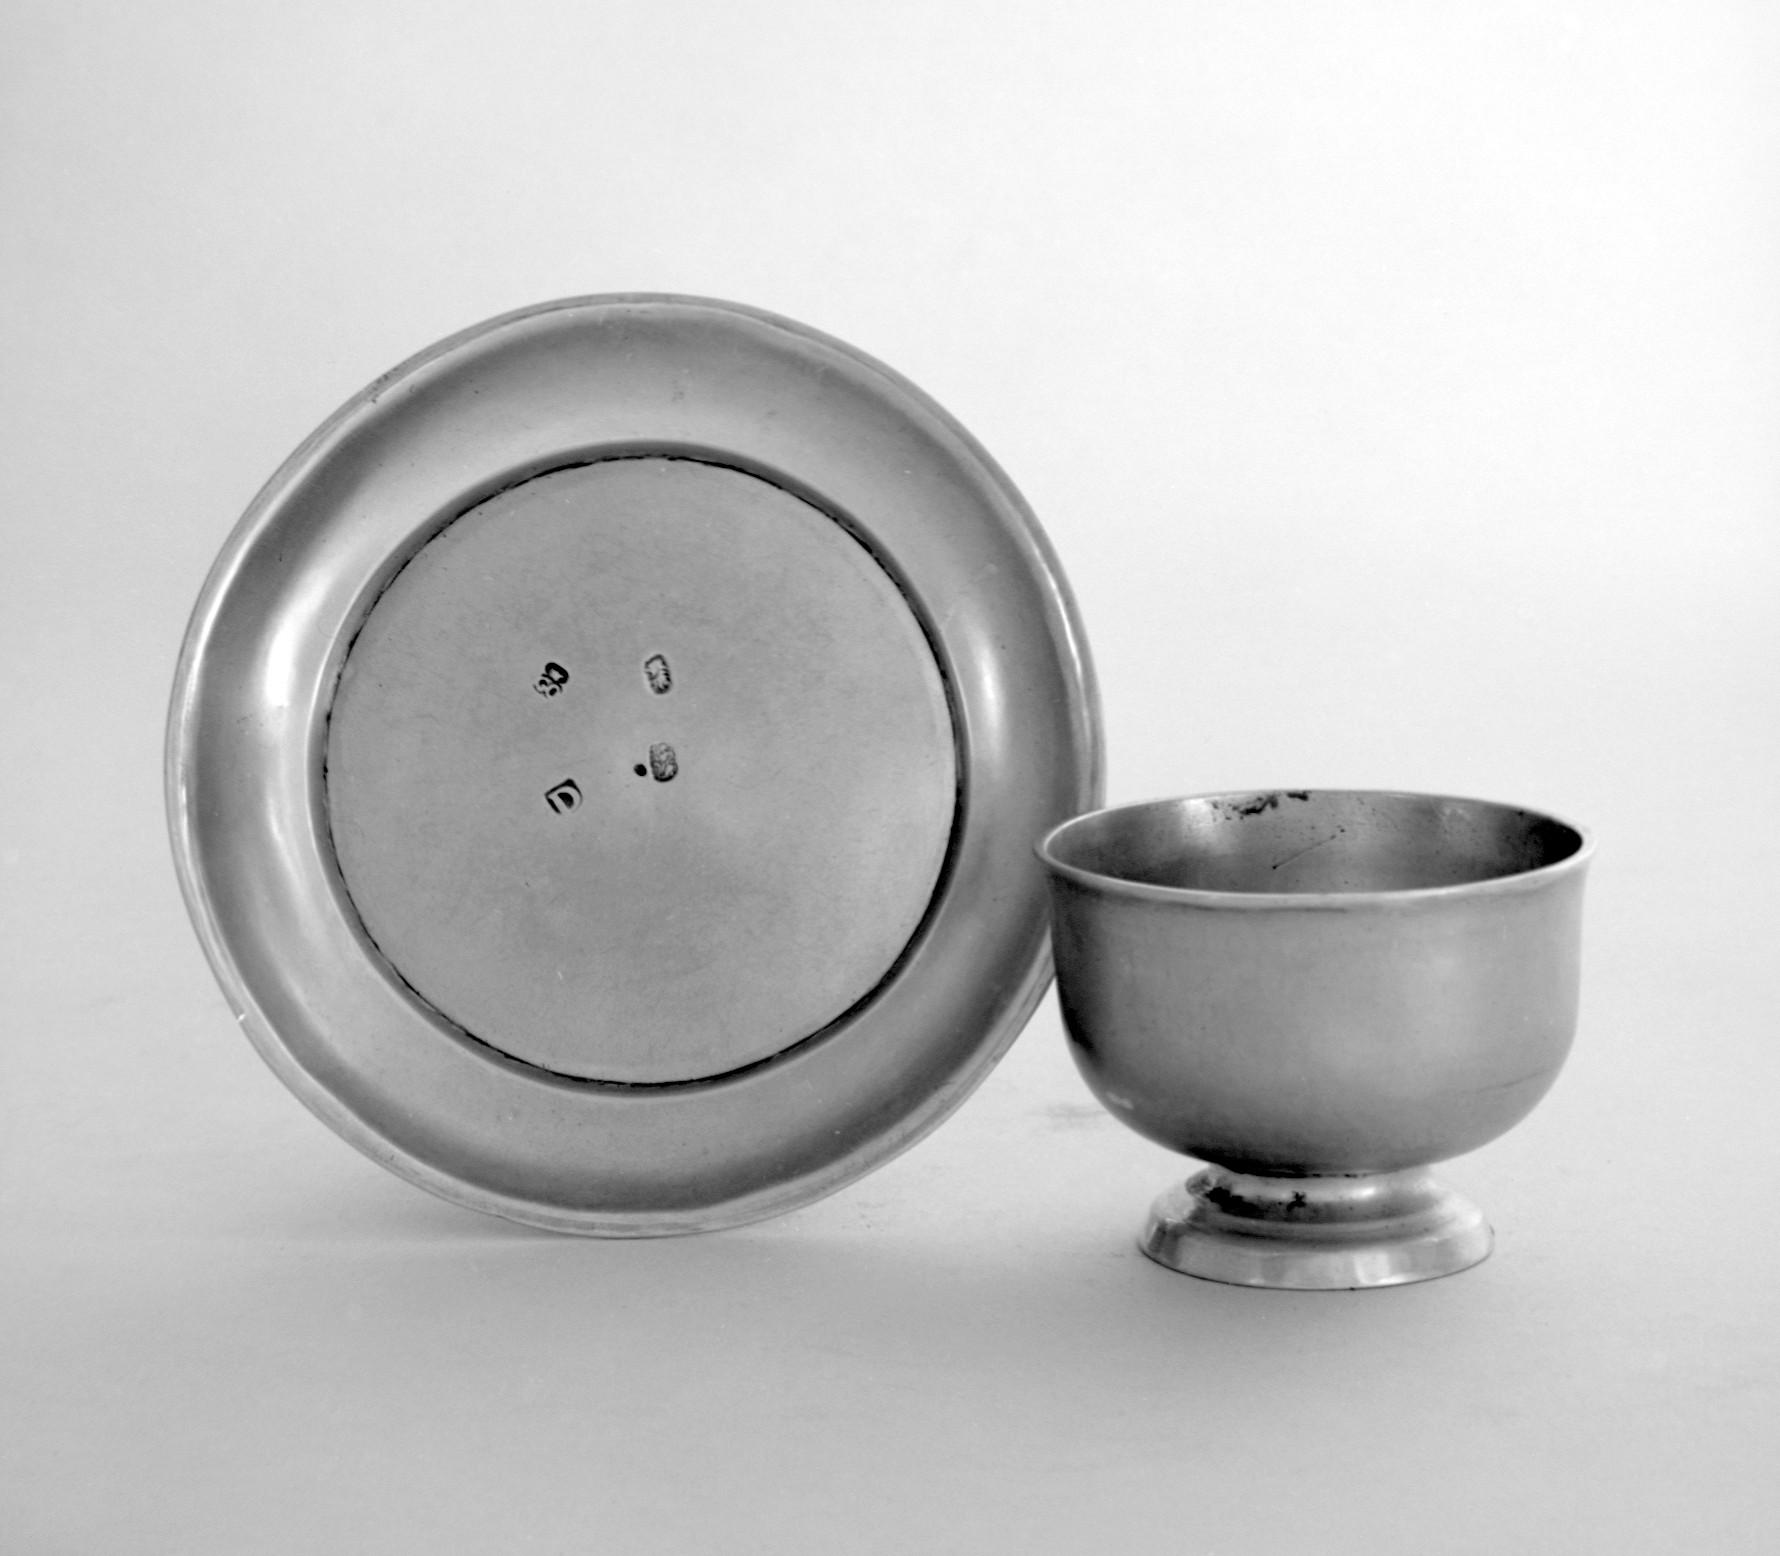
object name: teabowl and saucer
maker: john goode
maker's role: maker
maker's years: 1701-1713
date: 1719-1720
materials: silver